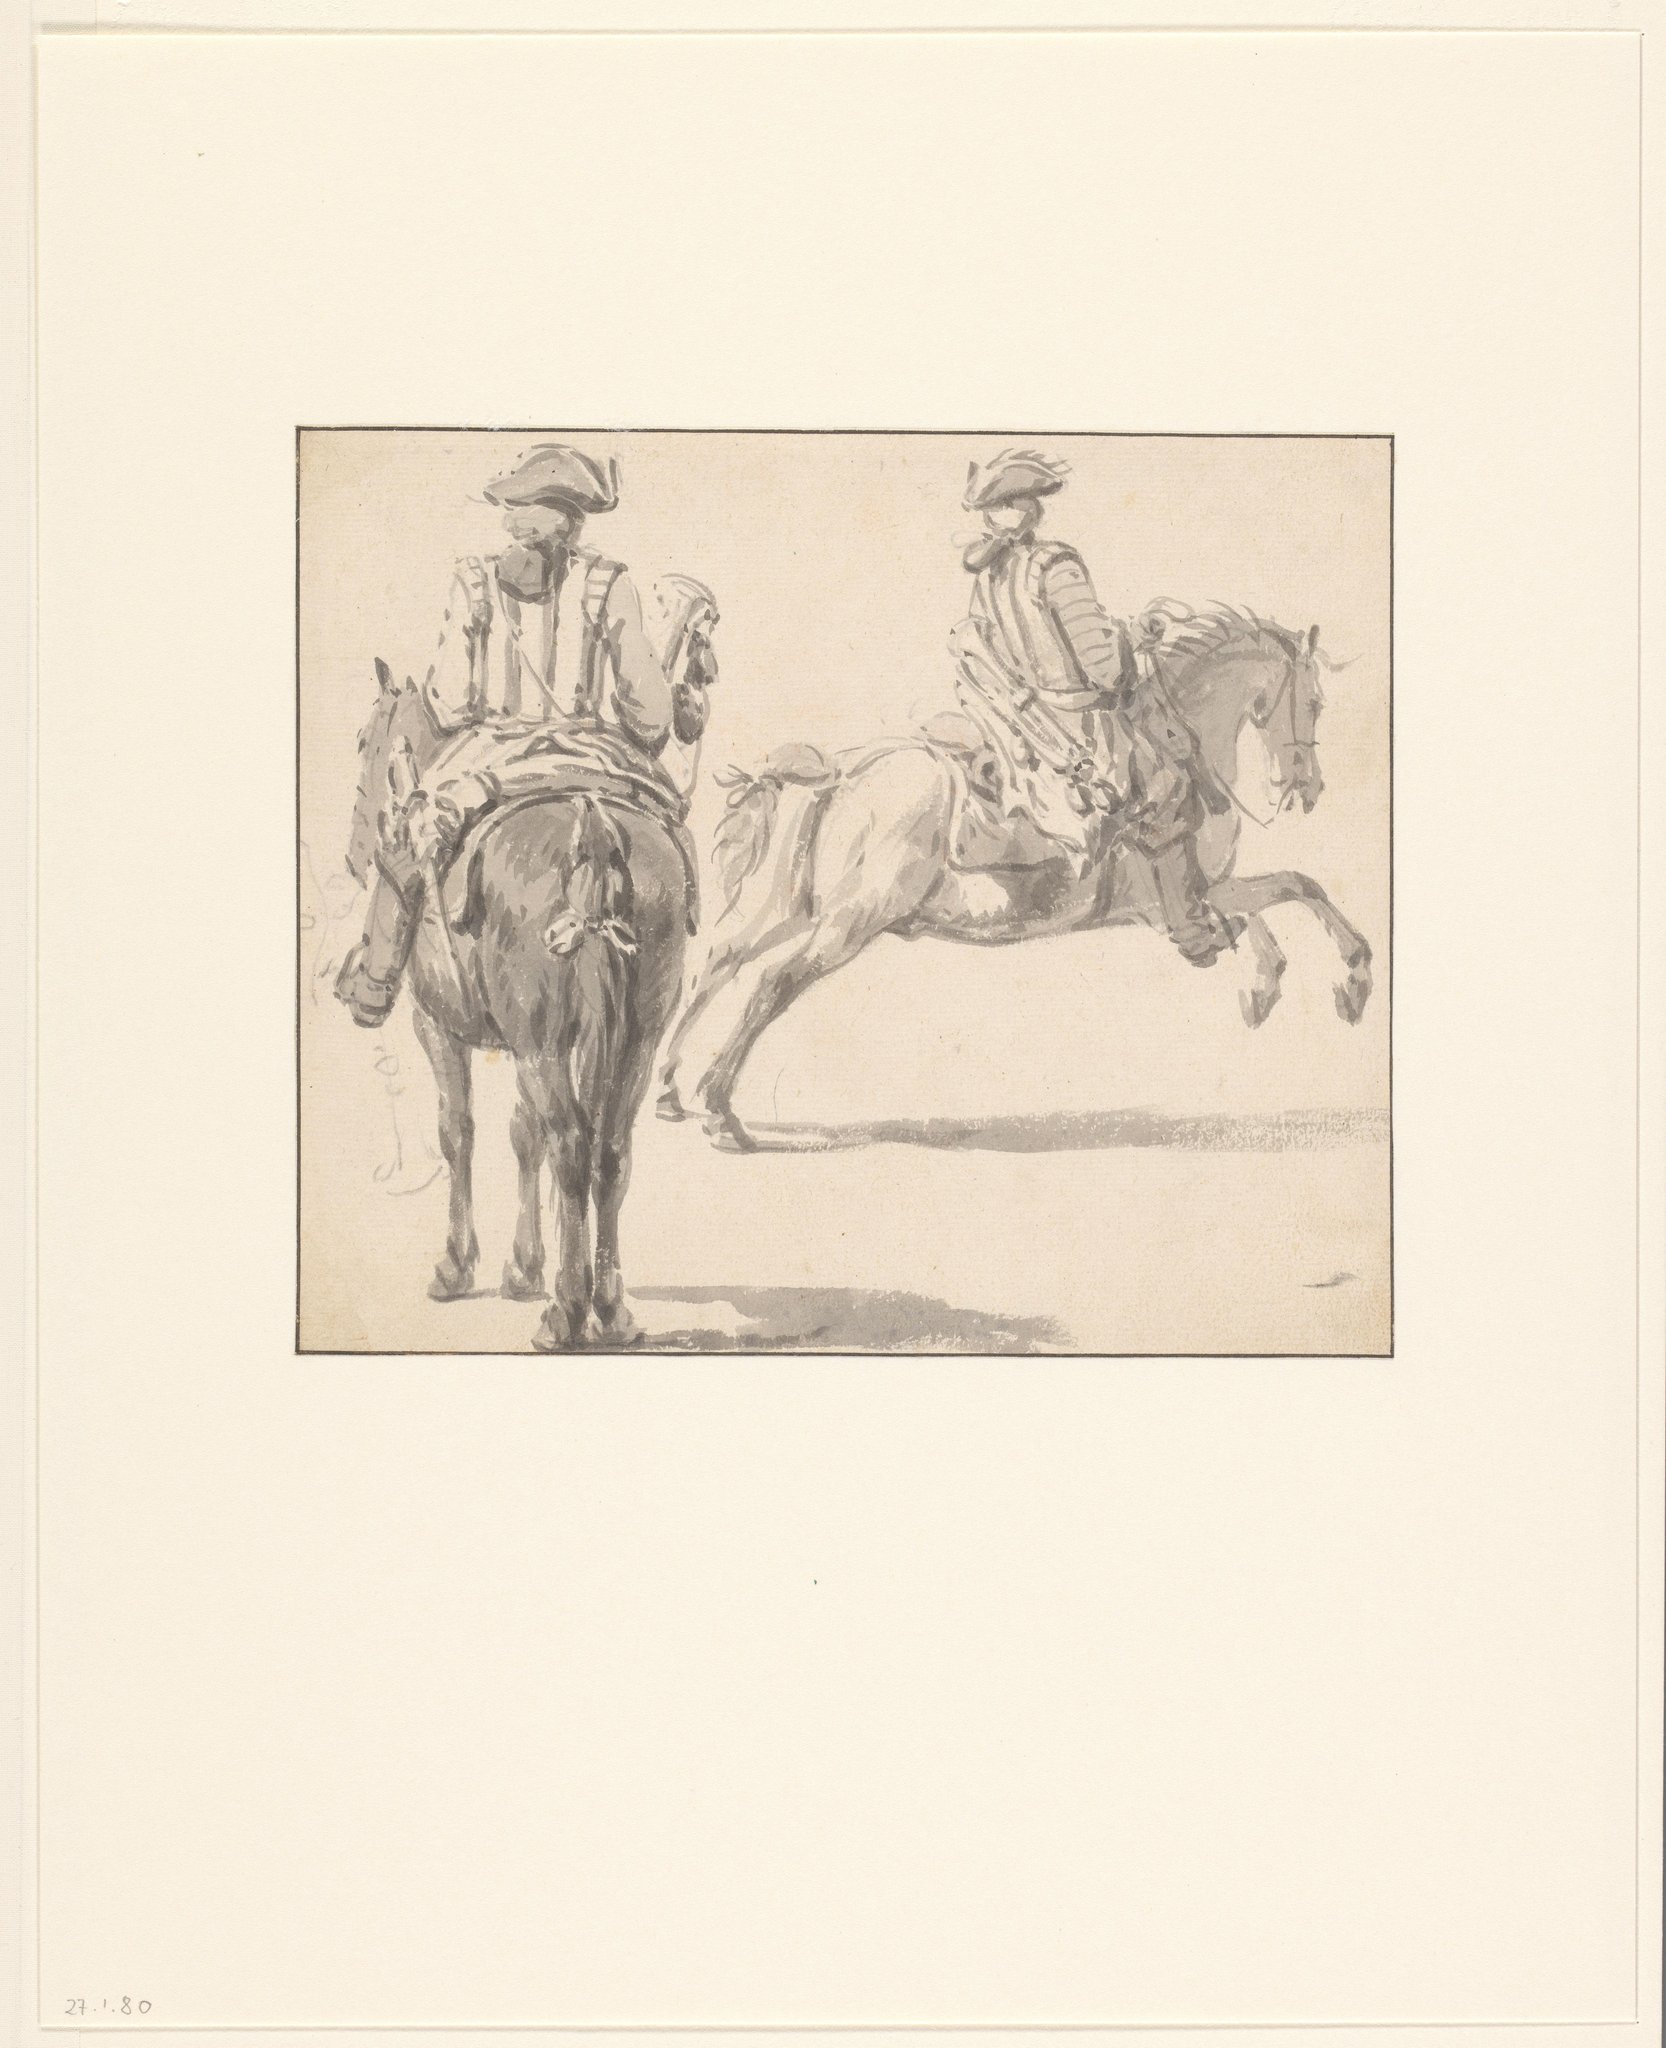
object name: drawing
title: Twee ruiters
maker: pieter van bloemen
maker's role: draughtsman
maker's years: 1657-1720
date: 1667-1720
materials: paper, pencil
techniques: brush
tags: riding a horse, ass, or mule; rider, horseman, land forces (+ cavalry, horsemen)